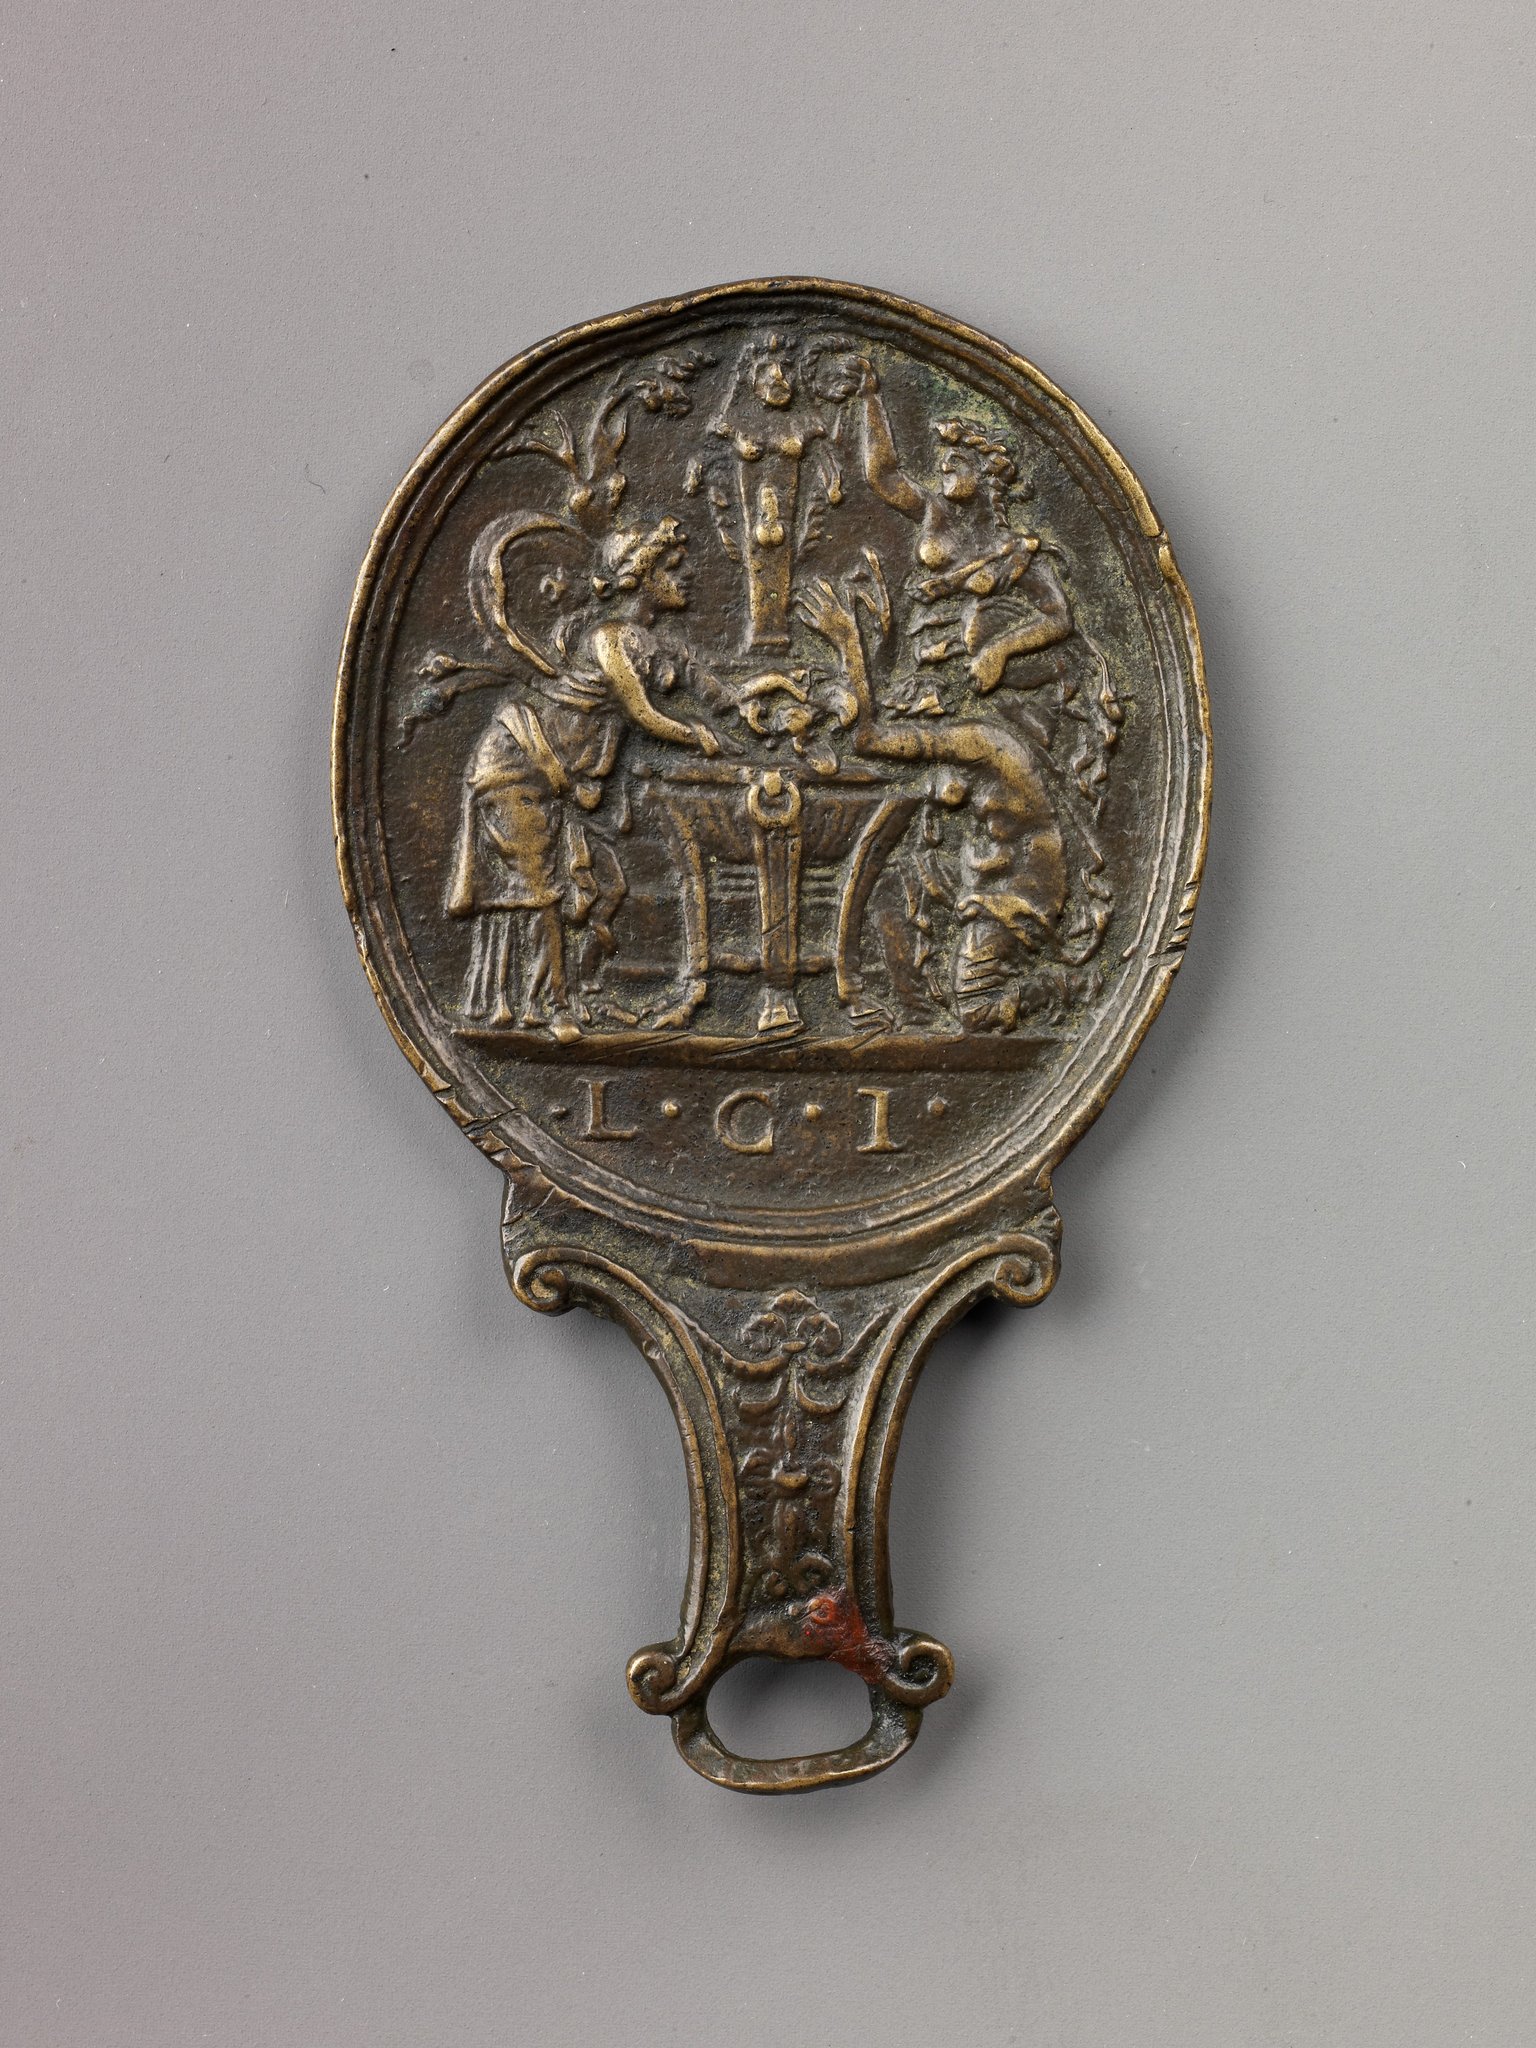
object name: plaquette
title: Sacrifice to Priapus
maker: cristoforo di geremia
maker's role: artist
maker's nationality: italian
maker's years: 1456-1476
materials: copper alloy, patina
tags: women